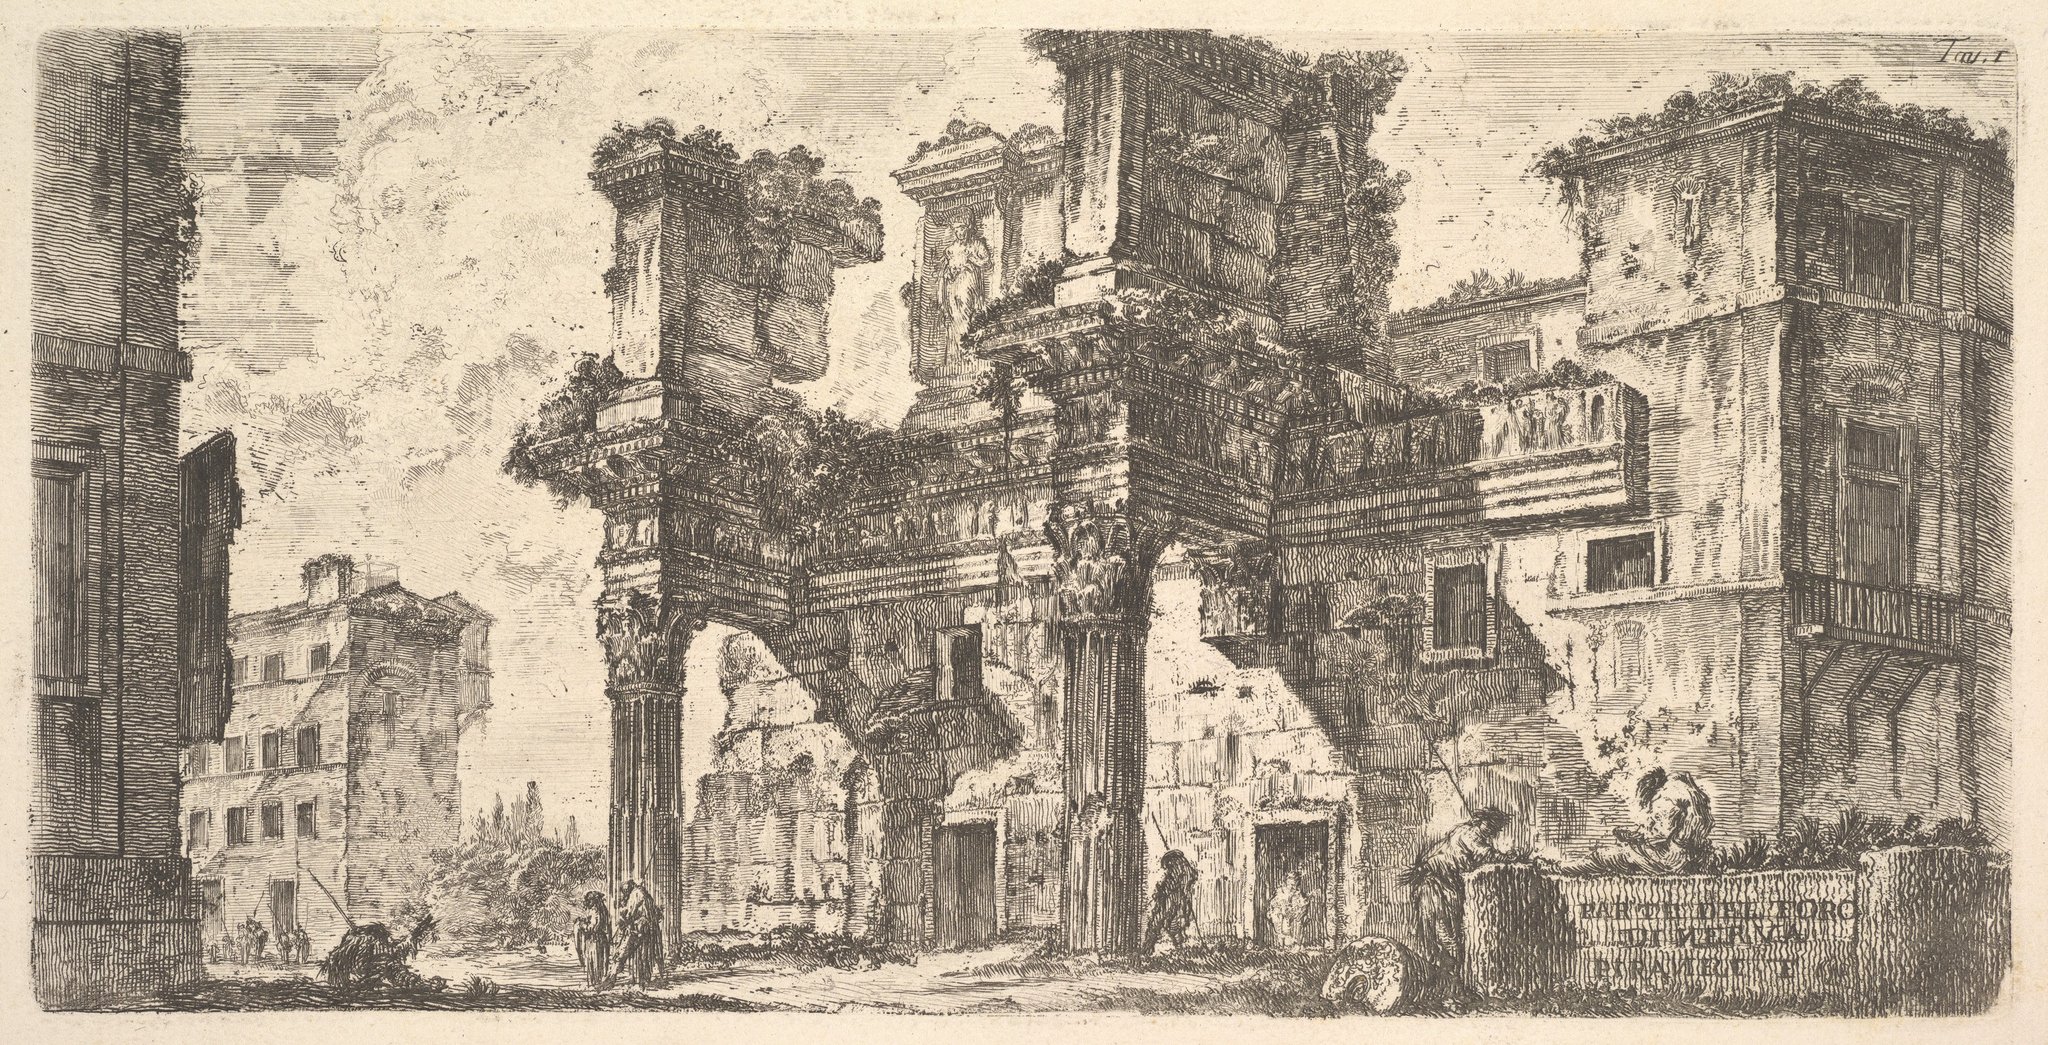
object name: print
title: Plate 1: Part of the Forum of Nerva (Parte del Foro di Nerva), from "Antichità Romane de' Tempi della Repubblica, e de' primi Imperatori"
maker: giovanni battista piranesi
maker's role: artist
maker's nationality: italian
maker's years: 1720-1778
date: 1748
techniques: etching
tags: architecture,ruins